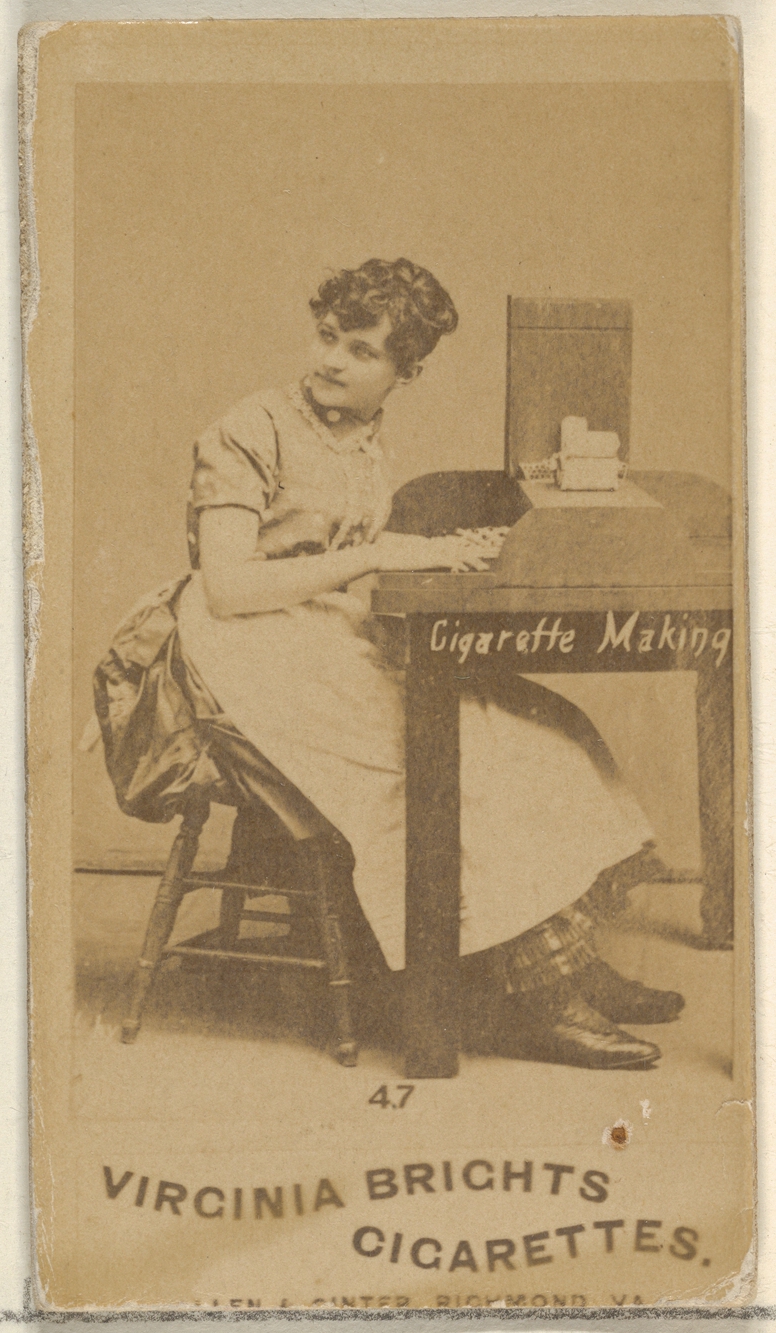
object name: photograph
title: Card 47, from the series, Cigarette Making Girls (N46) for Virginia Brights Cigarettes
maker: allen & ginter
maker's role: publisher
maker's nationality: american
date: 1888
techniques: albumen silver print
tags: girls,portraits